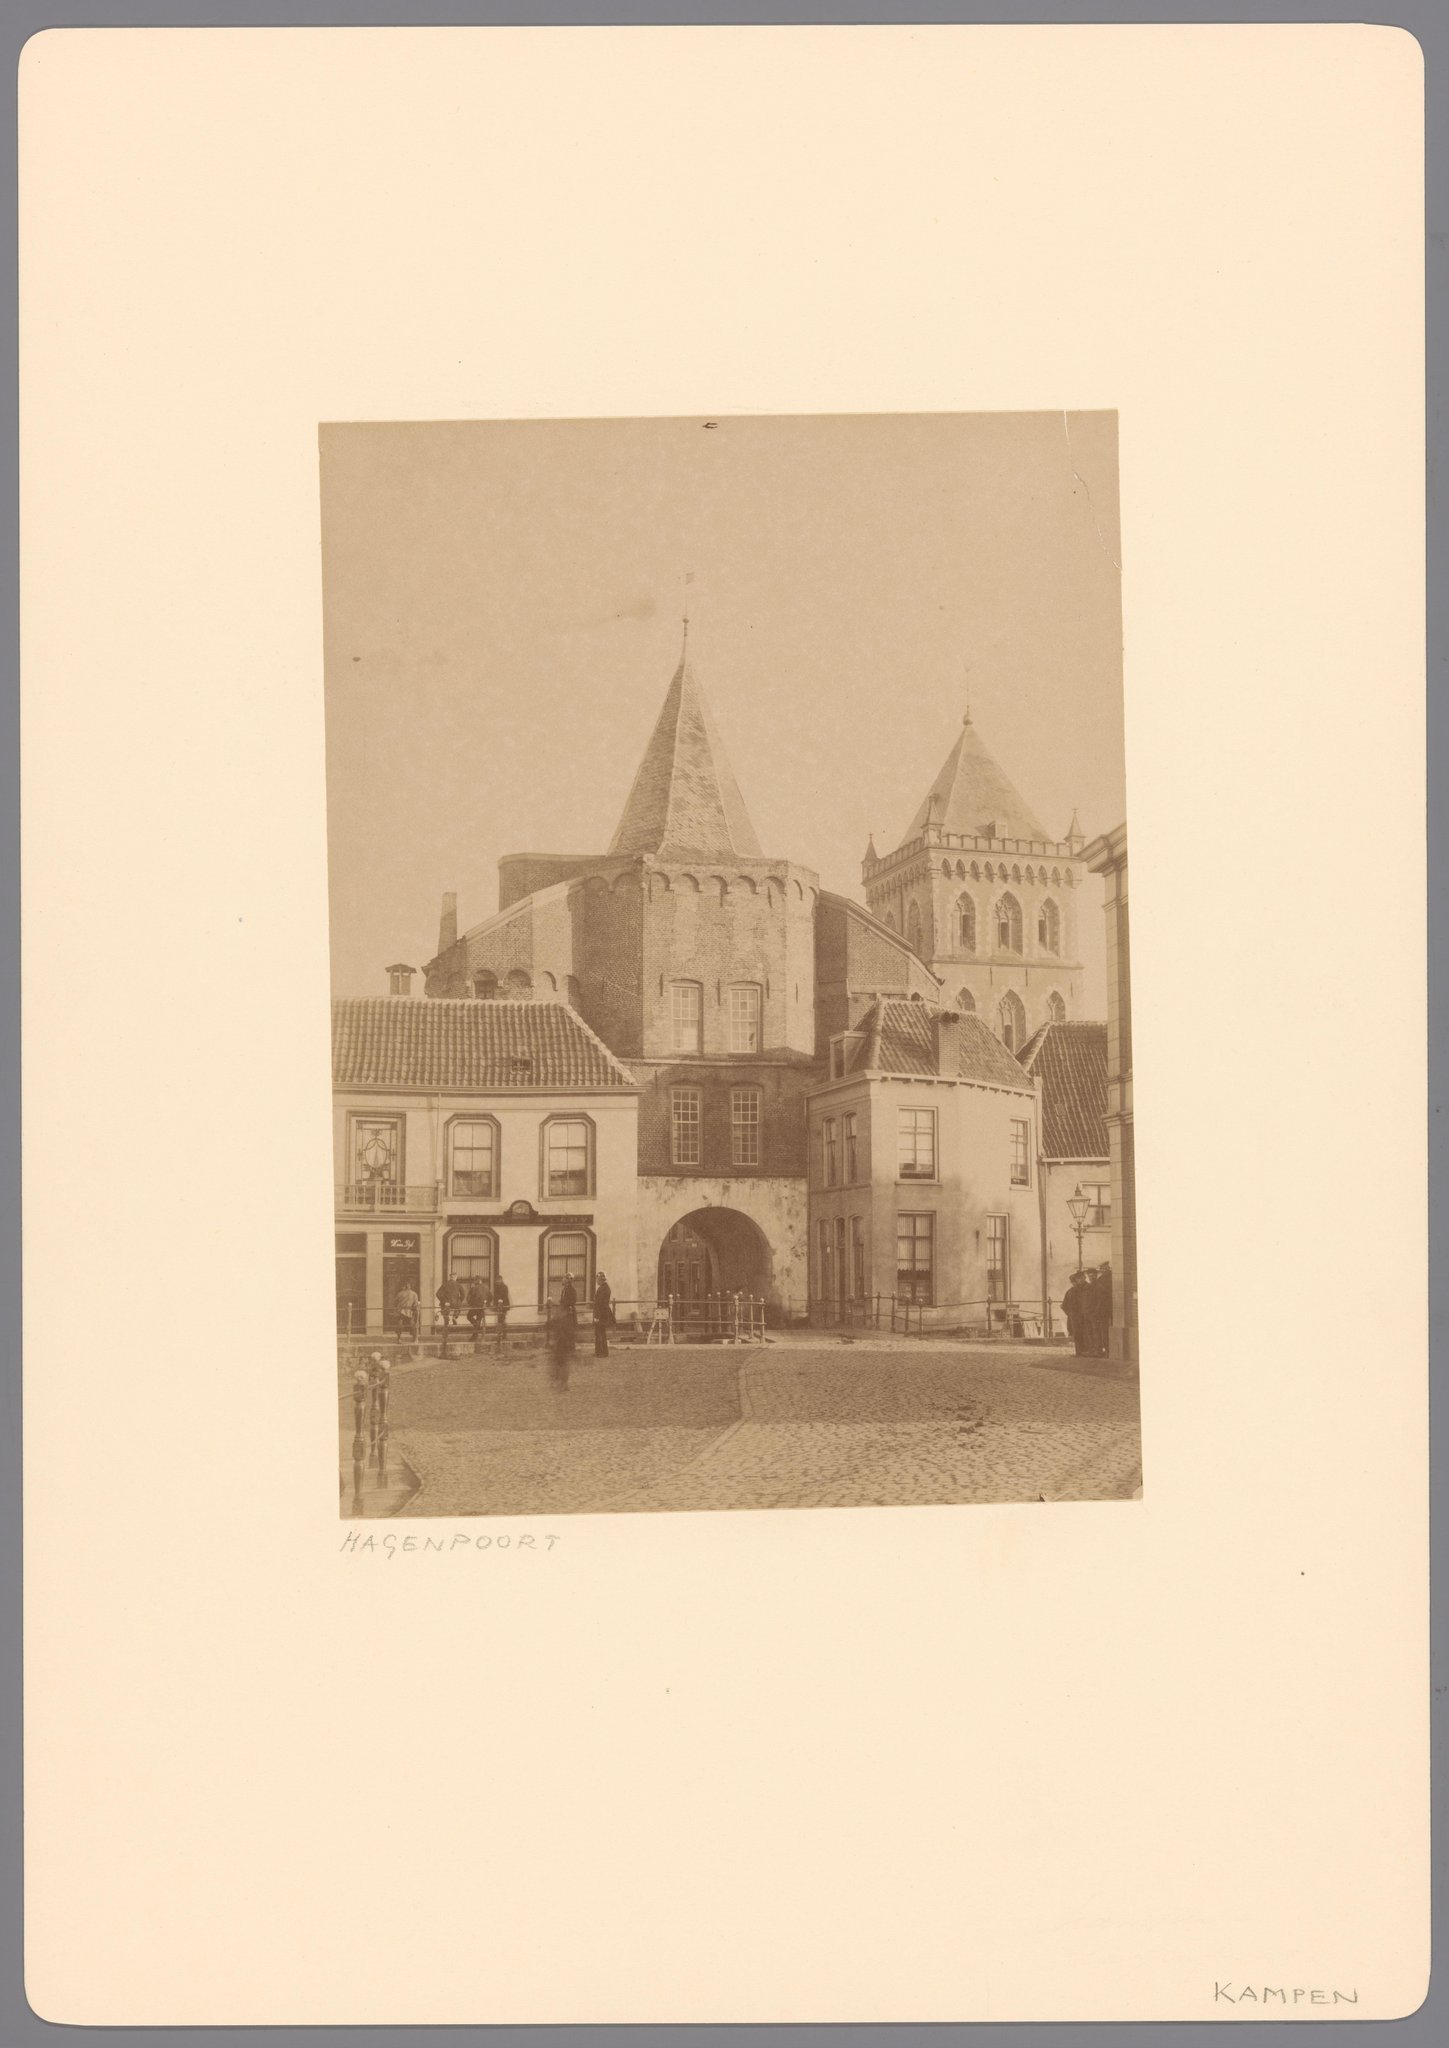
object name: photograph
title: Gezicht op de Hagenpoort te Kampen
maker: anoniem (monumentenzorg)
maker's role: fotograaf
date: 1890-1910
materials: cardboard, photographic support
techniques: albumen print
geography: kampen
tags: city-gate (+ city(-scape) with figures, staffage), street (+ city(-scape) with figures, staffage)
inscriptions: annotation: ‘Hagenpoort/ Kampen’, annotation: ‘Kampen/ Hagenpoort’